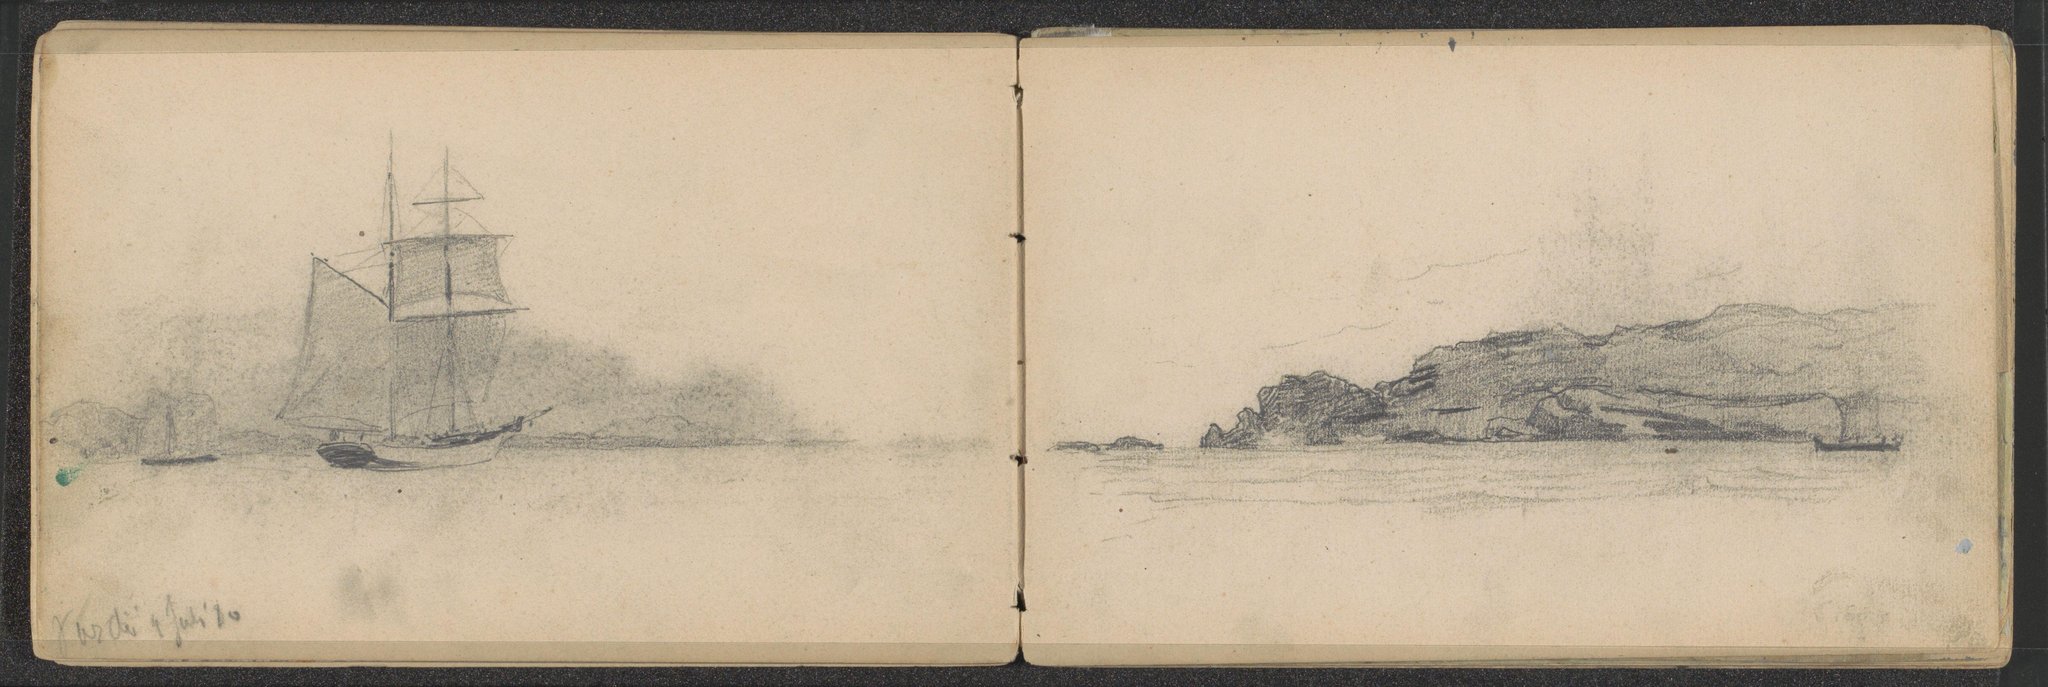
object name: sketchbook leaf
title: Schepen op de Barentszzee nabij Vardø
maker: louis apol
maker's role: draughtsman, painter, print maker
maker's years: 1850-1936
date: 1880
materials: paper, pencil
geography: vardø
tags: ships (in general), sea (seascape)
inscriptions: annotation: ‘Varde 4 Juli 80’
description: Blad 13 verso uit een schetsboek met 35 bladen betekend tijdens de expeditie naar Nova Zembla in 1880.